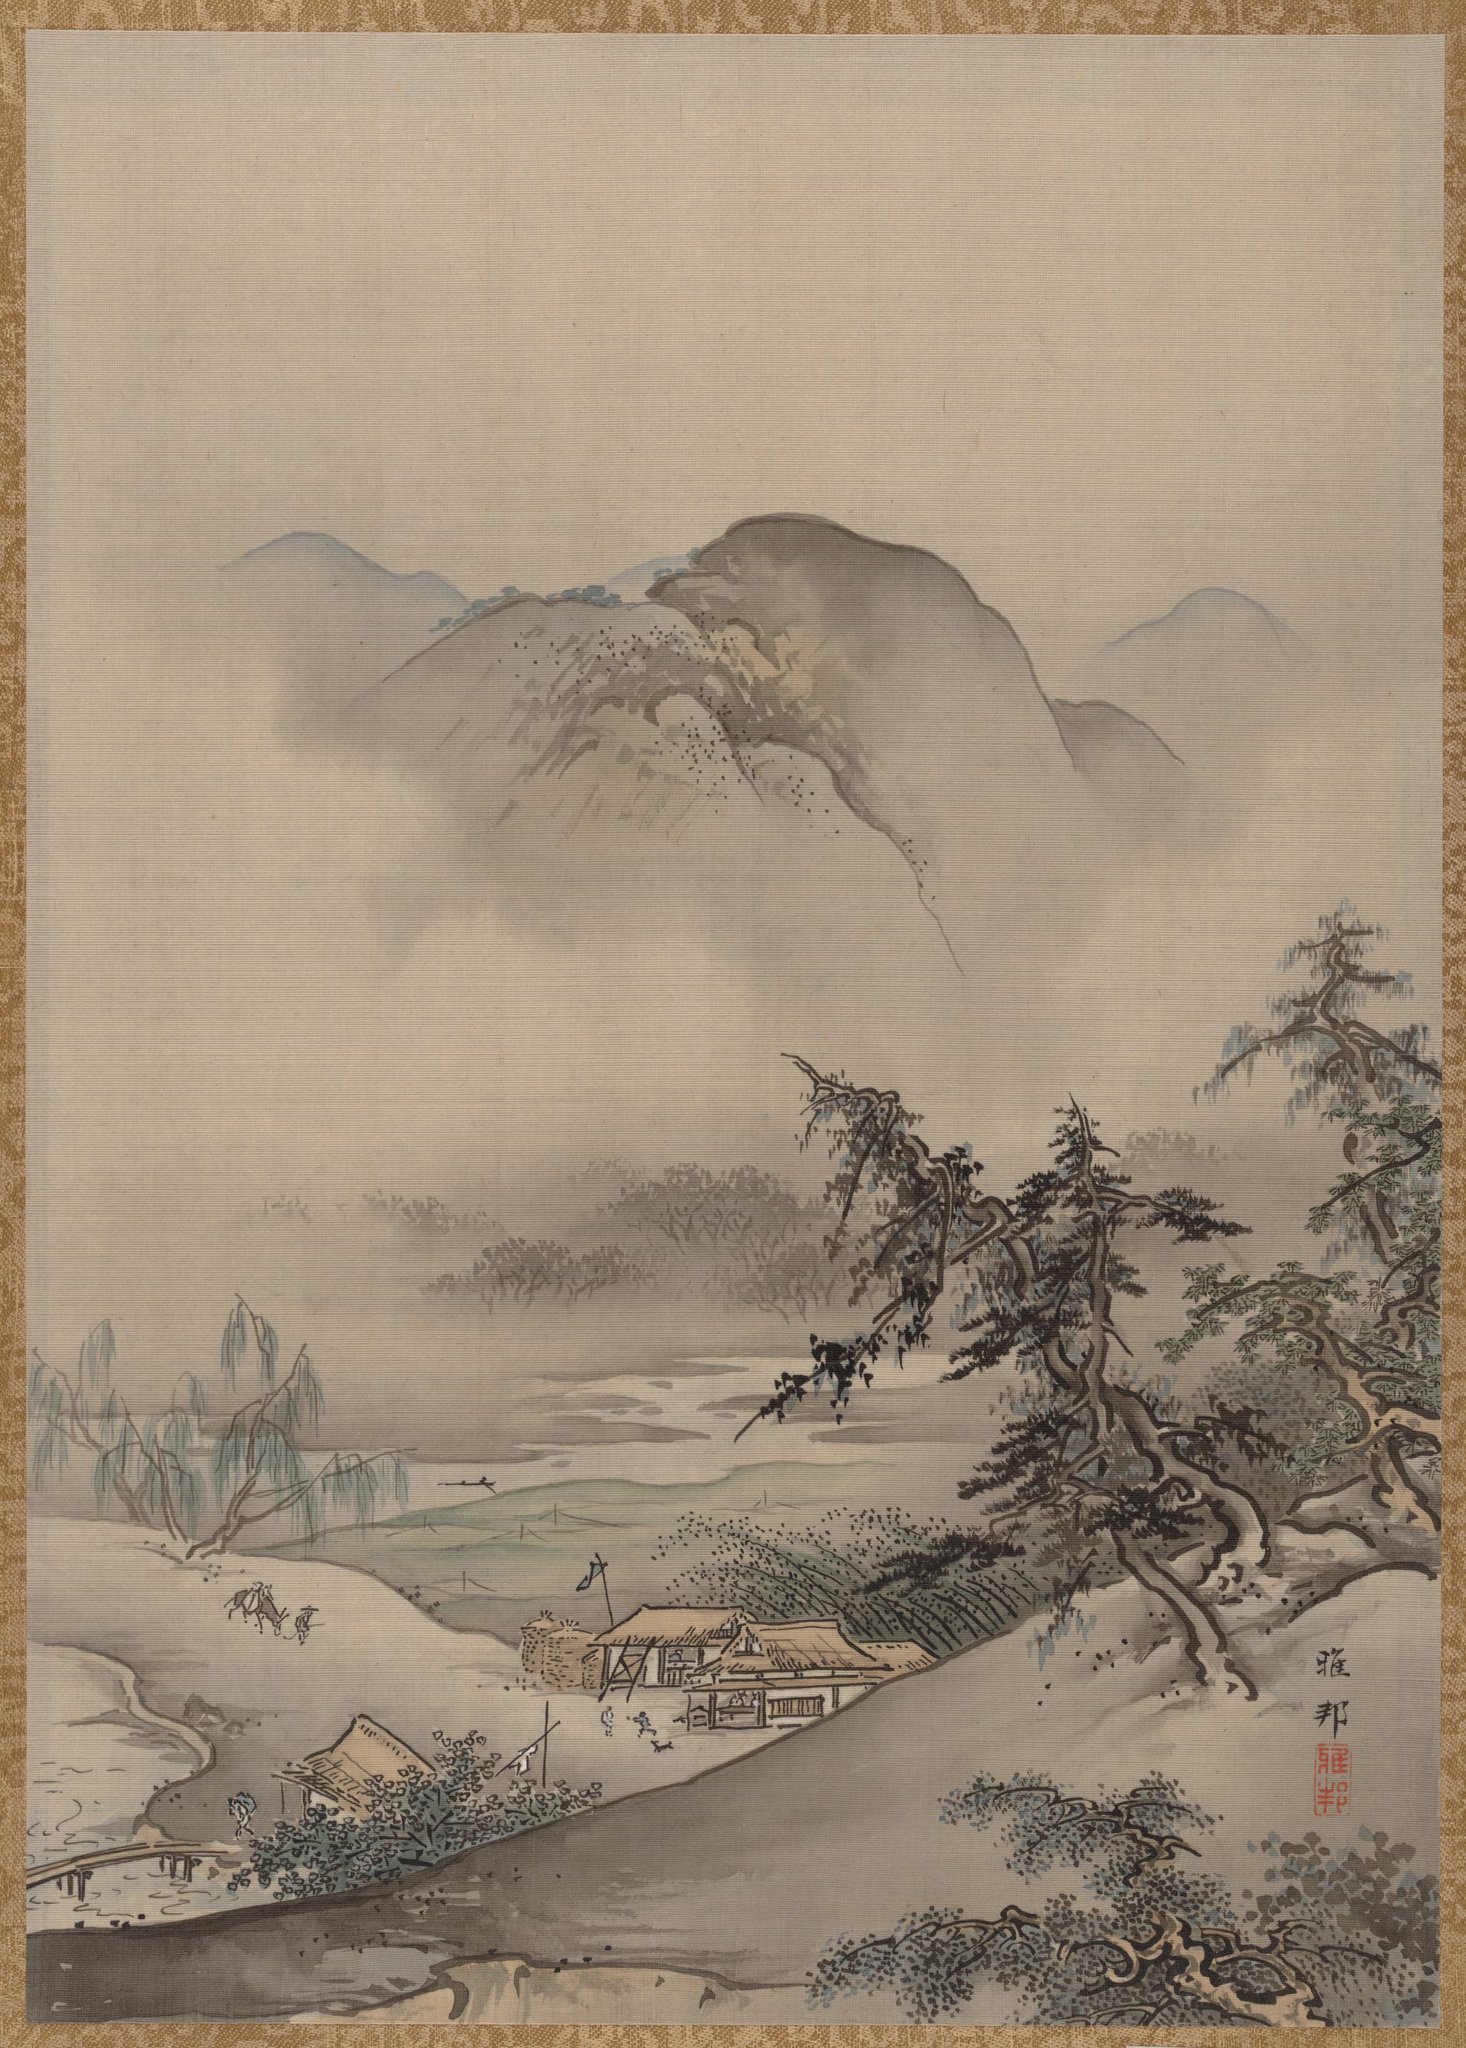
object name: album leaf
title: Landscape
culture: japanese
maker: hashimoto gahō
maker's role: artist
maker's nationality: japanese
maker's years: 1835-1908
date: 1885-1889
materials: ink, silk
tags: mountains,landscapes